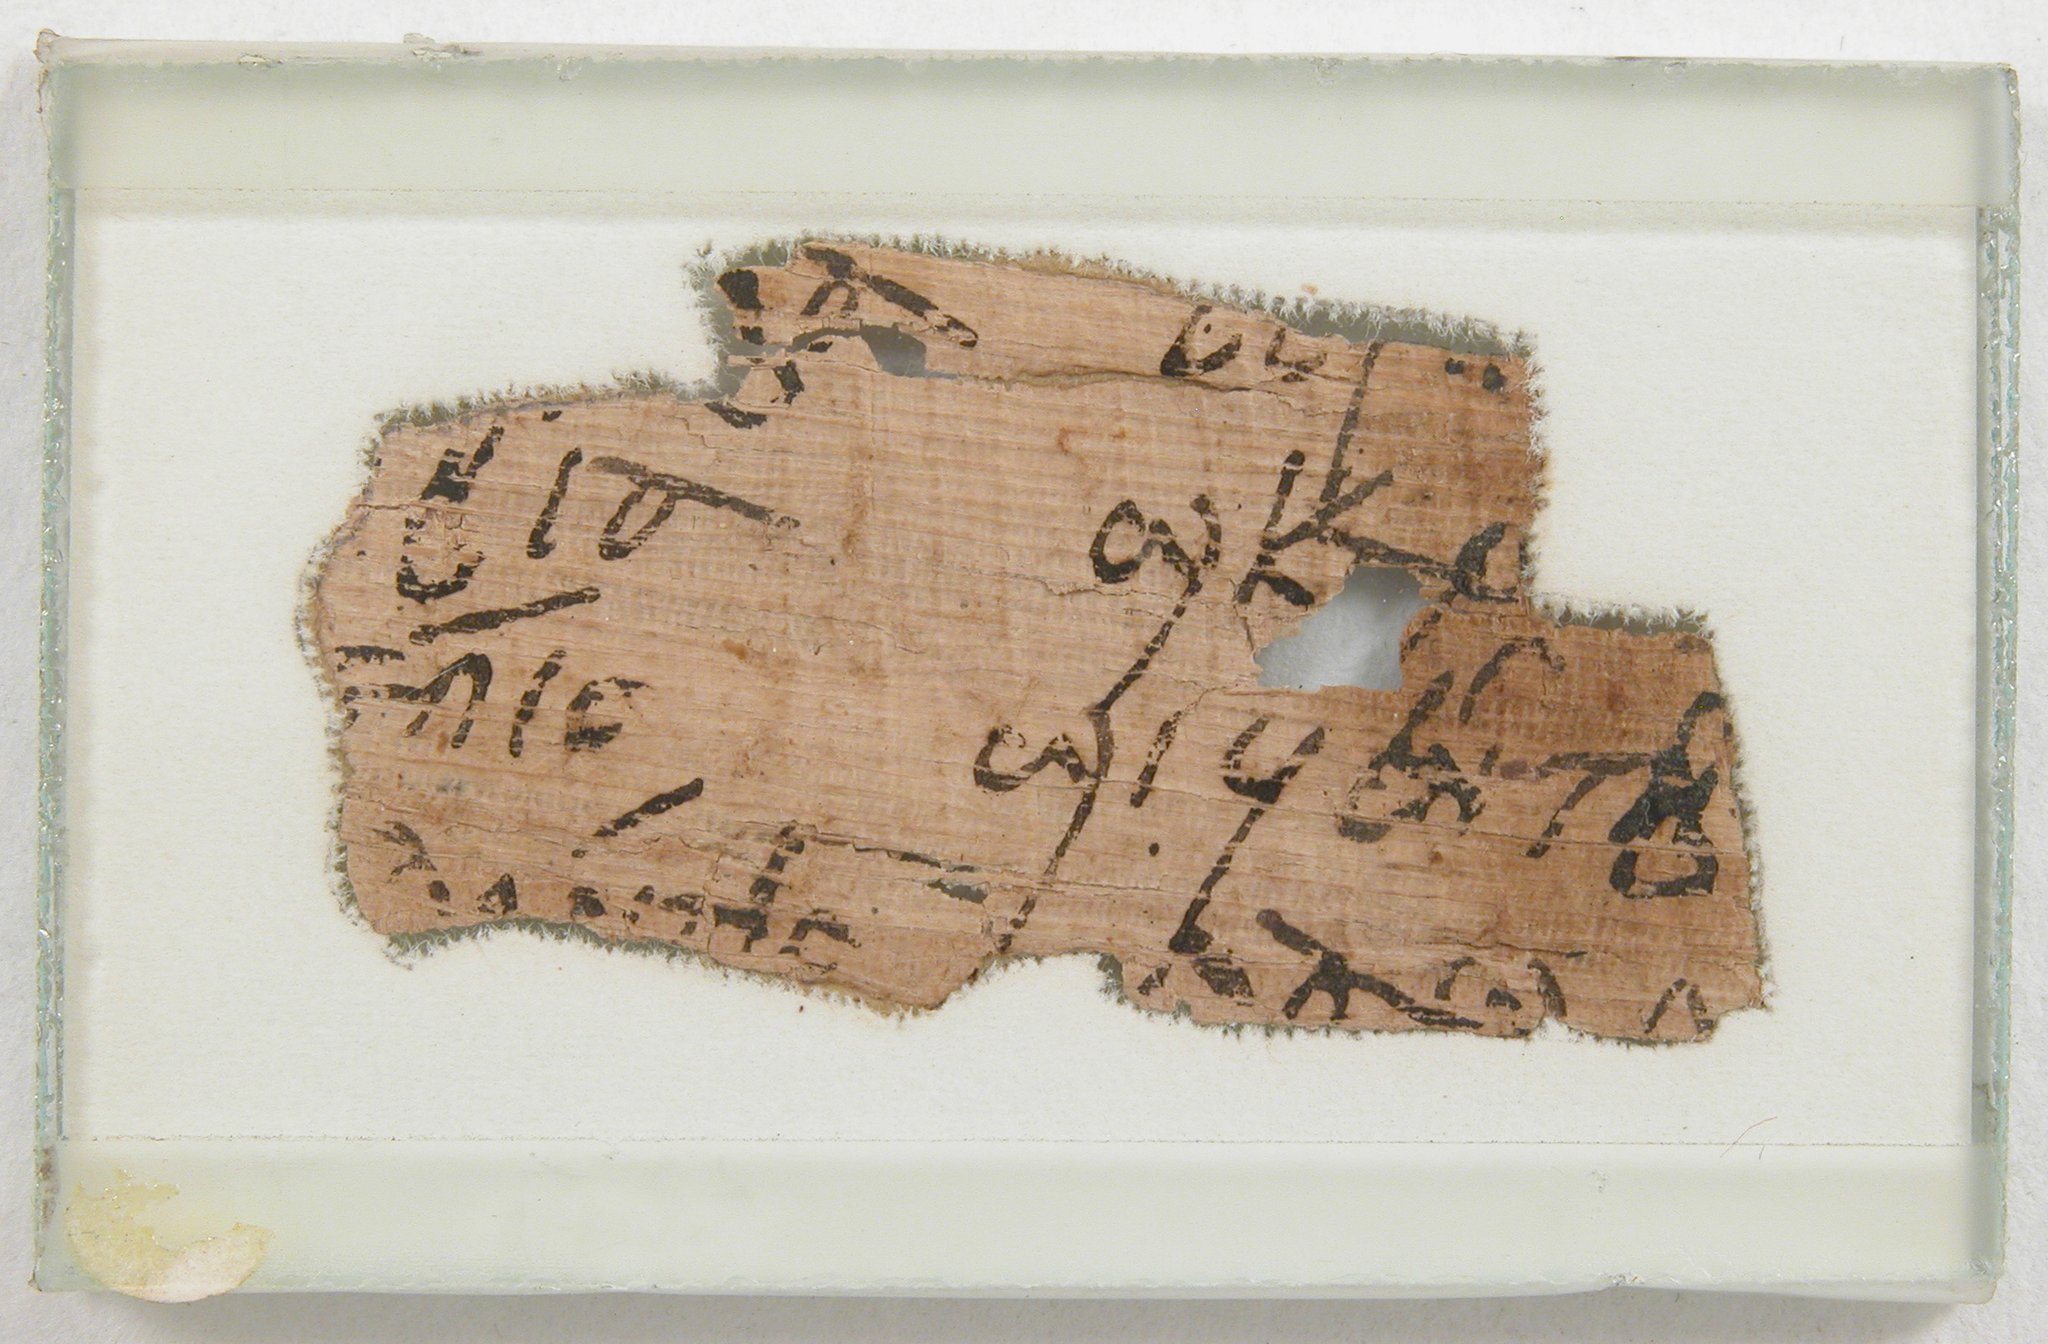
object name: fragment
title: Papyrus Fragment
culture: coptic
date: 580-640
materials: ink, papyrus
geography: egypt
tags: coptic,documents